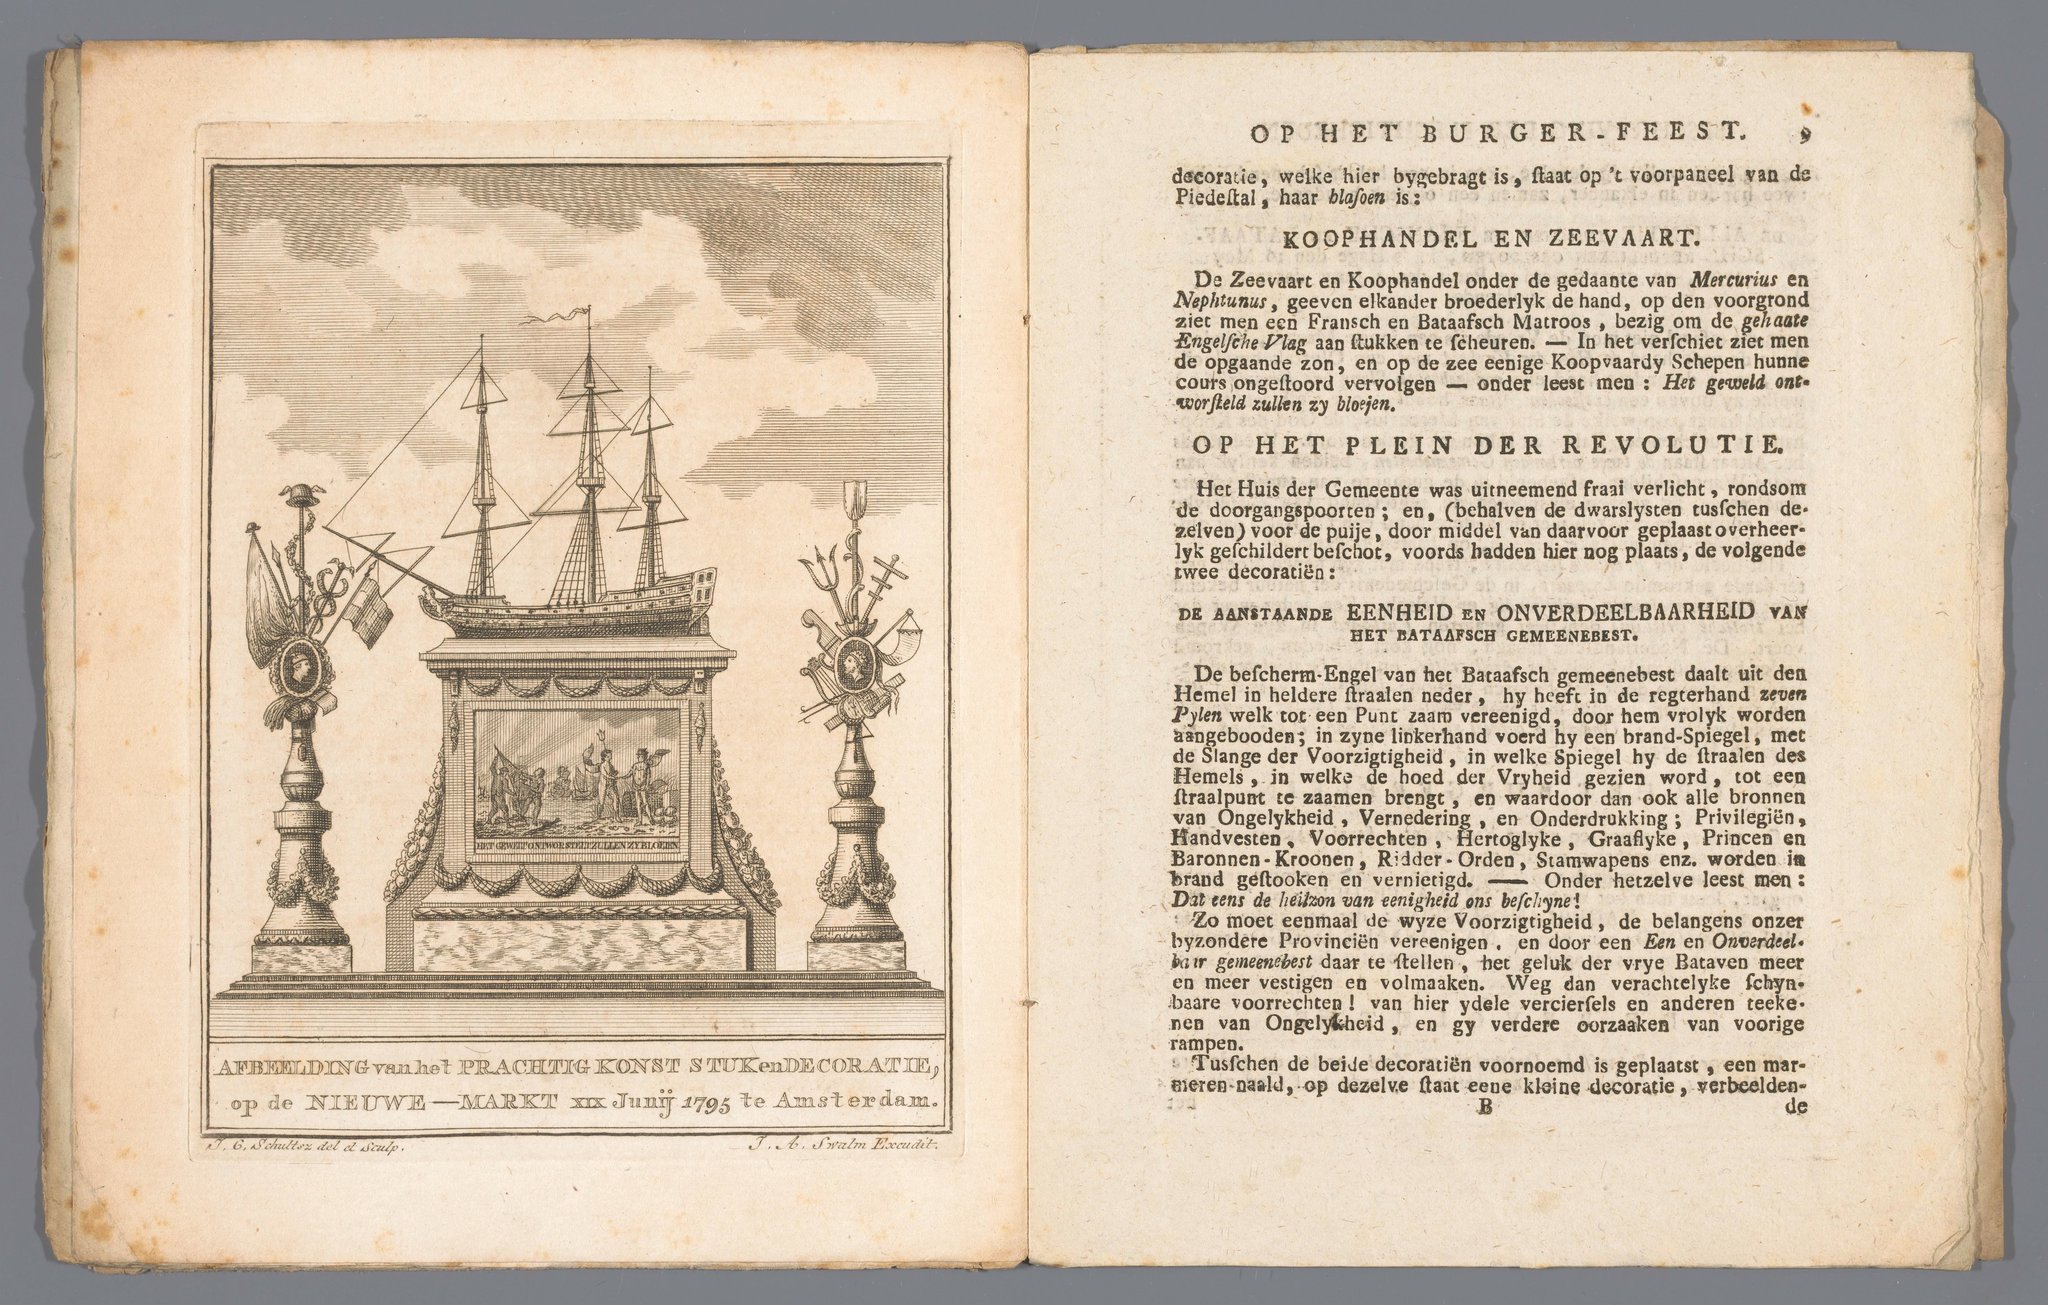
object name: print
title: Koophandel en Zeevaart, decoratie op de Nieuwmarkt, 1795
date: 1795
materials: paper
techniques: engraving, etching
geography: amsterdam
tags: ship-model (+ propulsion of vehicle, ship, etc. by wind), festivities on events of national importance (+ festive decoration ~ festive activities), alliance with france (1795)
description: Koophandel en Zeevaart, allegorische decoratie opgericht in de Nieuwmarkt te Amsterdam bij het Alliantiefeest op 19 juni 1795. Reusachtig model van een koopvaardijschip op een voetstuk met chassinet met voorstelling van Neptunus en Mercurius die elkaar de hand schuppen terwijl de Franse en Bataafse matroos de Britse vlag aan stukken scheuren.